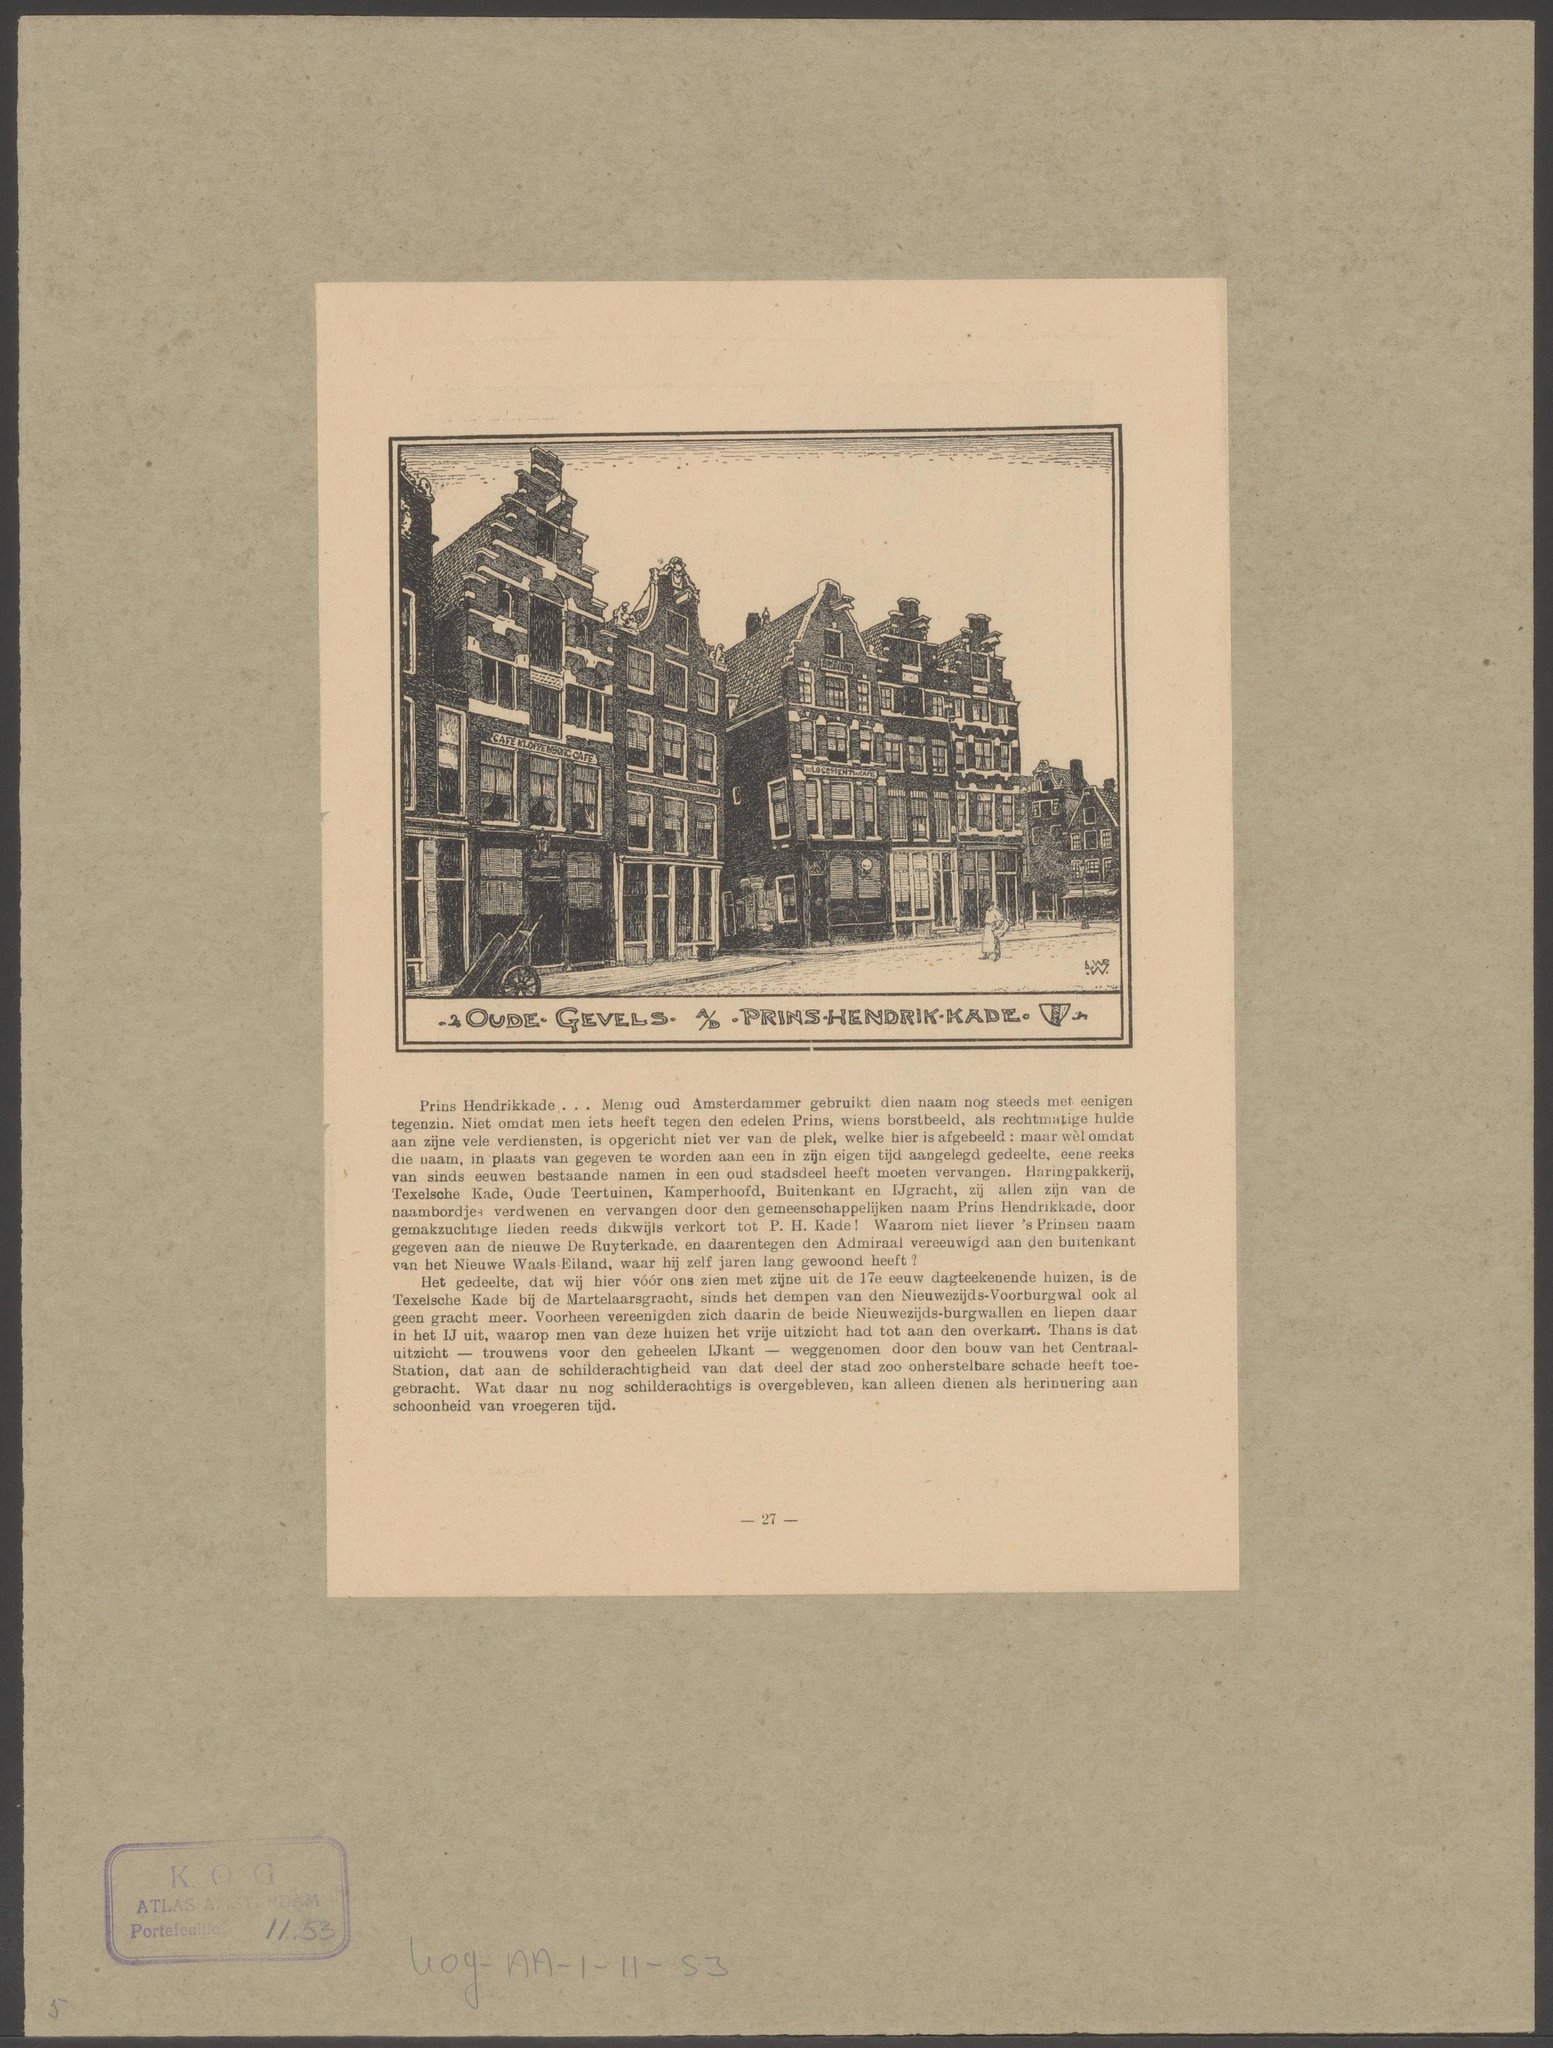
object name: page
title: Oud-Amsterdam 100 Stadsgezichten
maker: willem wenckebach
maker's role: designer, draughtsman, painter, print maker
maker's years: 1860-1937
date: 1870-1923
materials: paper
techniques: letterpress printing, line block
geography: amsterdam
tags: city-view in general; 'veduta', the usual house or row of houses, façade (of house or building), street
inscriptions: collector's mark: ‘11.53’ Lugt 1641b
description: Onderwerpsrubriek binnen de Atlas Amsterdam: Prinsengracht, Korte Prinsengracht, Prins Hendrikkade. Zie ook Portefeuille 1: gezichten van het IJ op de stad.